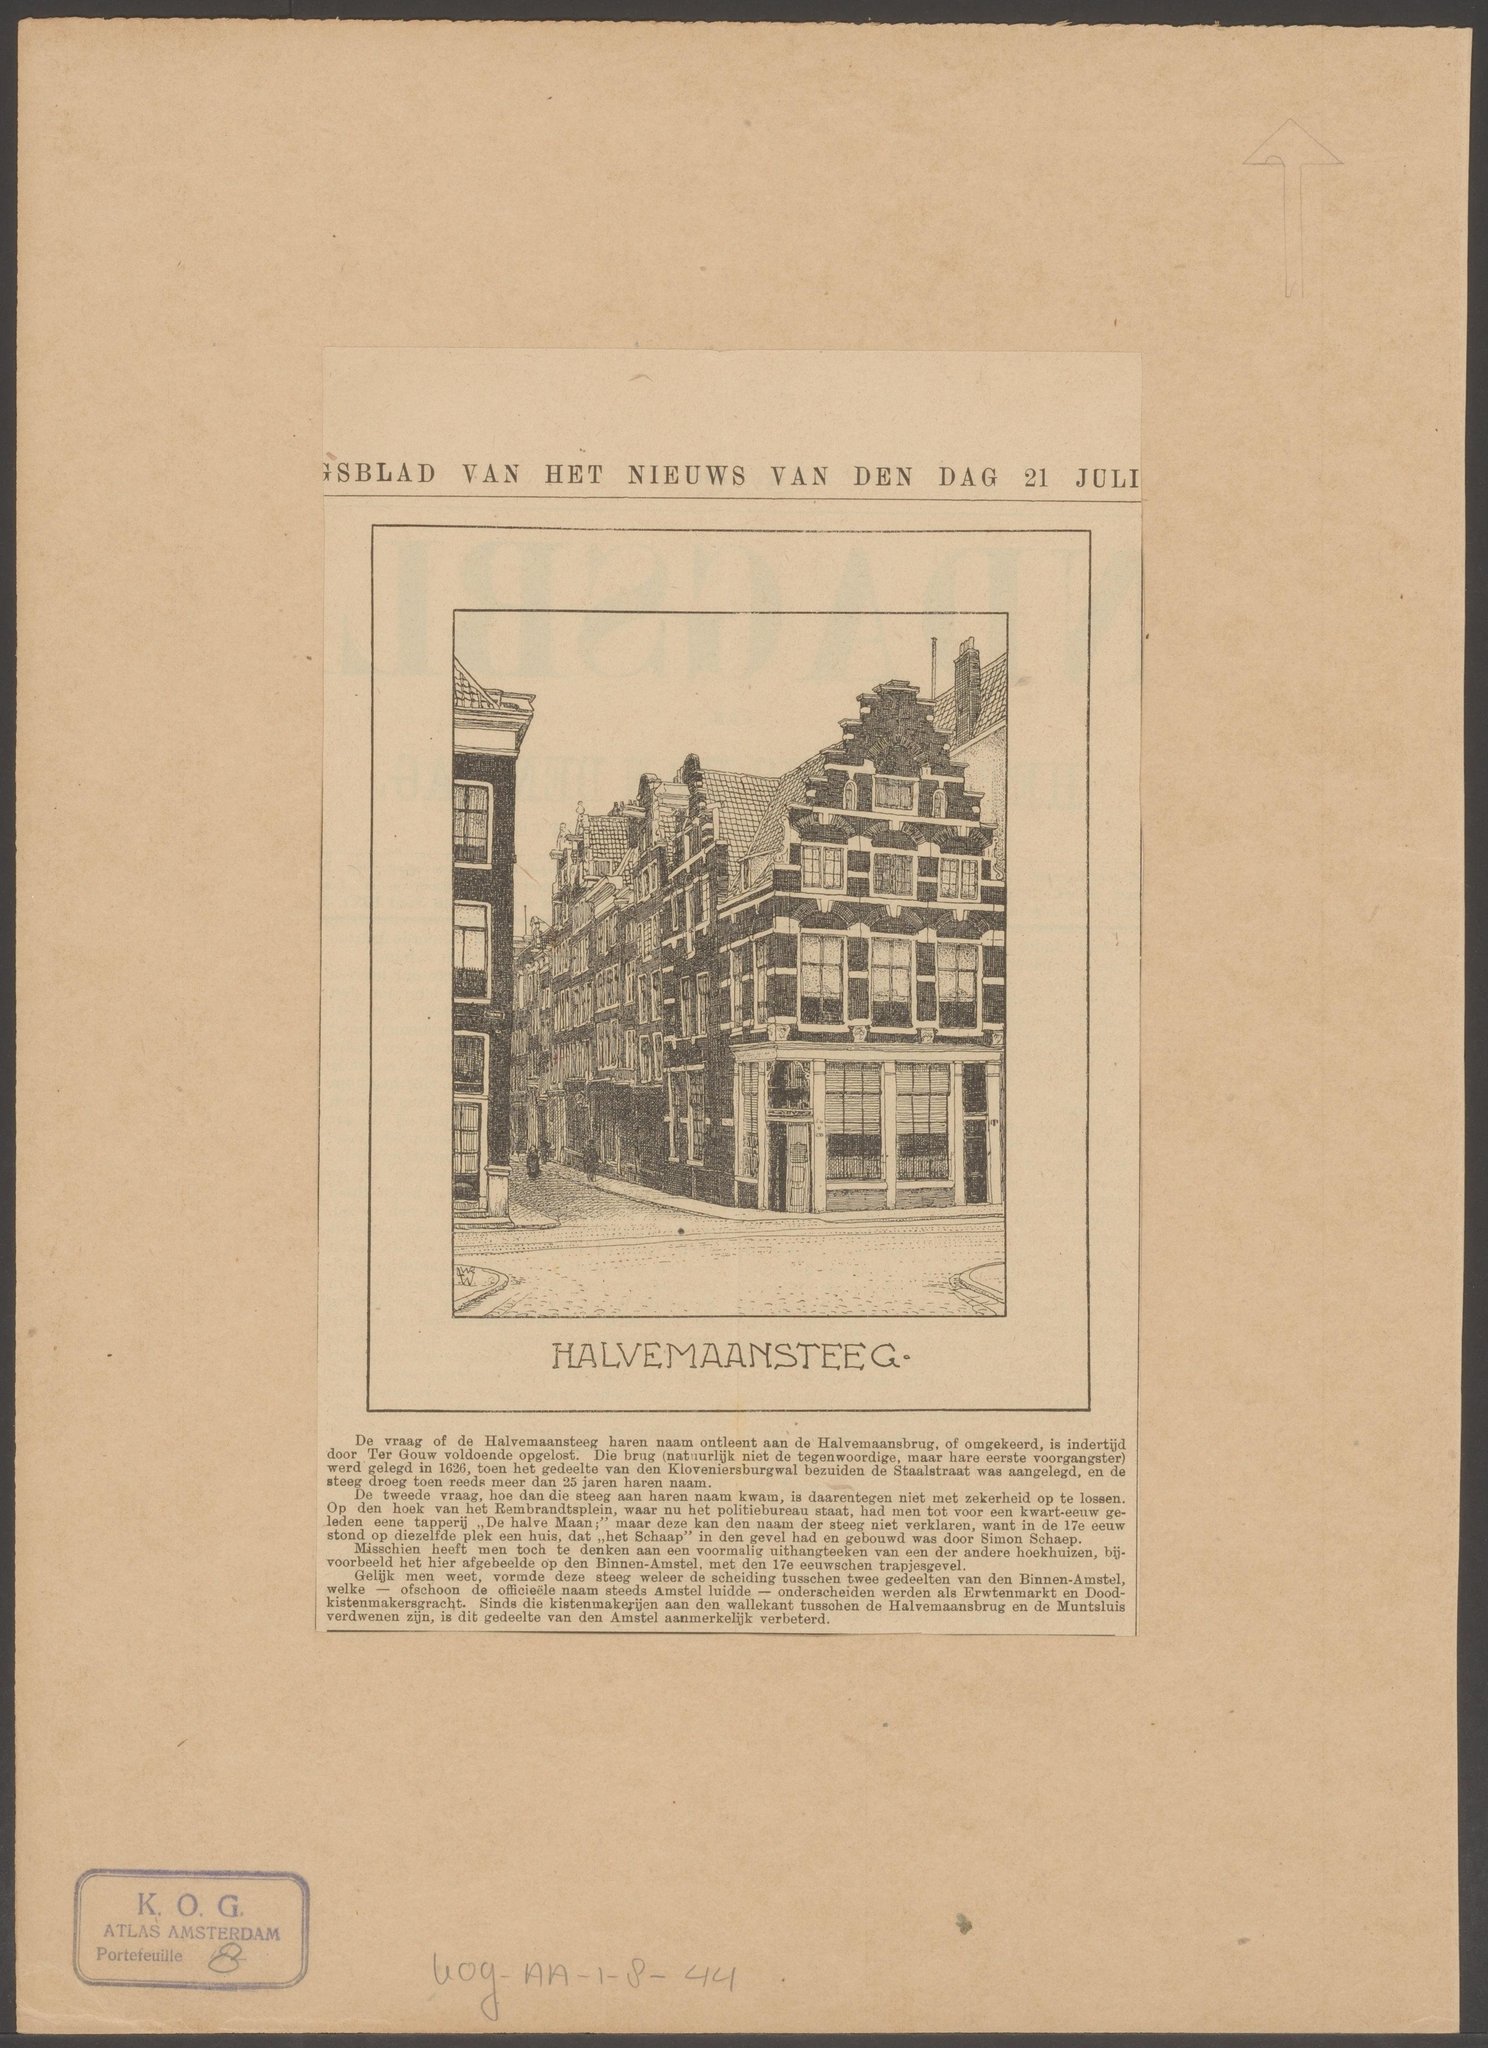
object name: photomechanical print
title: Gezicht op de Halvemaansteeg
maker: Anonymous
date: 1800-1899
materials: paper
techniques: letterpress printing, line block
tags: city-view in general; 'veduta', the usual house or row of houses, street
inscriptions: collector's mark: ‘8’ Lugt 1641b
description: Onderwerpsrubriek binnen de Atlas Amsterdam: Haarlemmerplein, Halvemaansteeg, Handboogstraat, Handelskade, Haringpakkerij, Hartenstraat, Hasseltsteeg (Dirk van), Heerengracht.